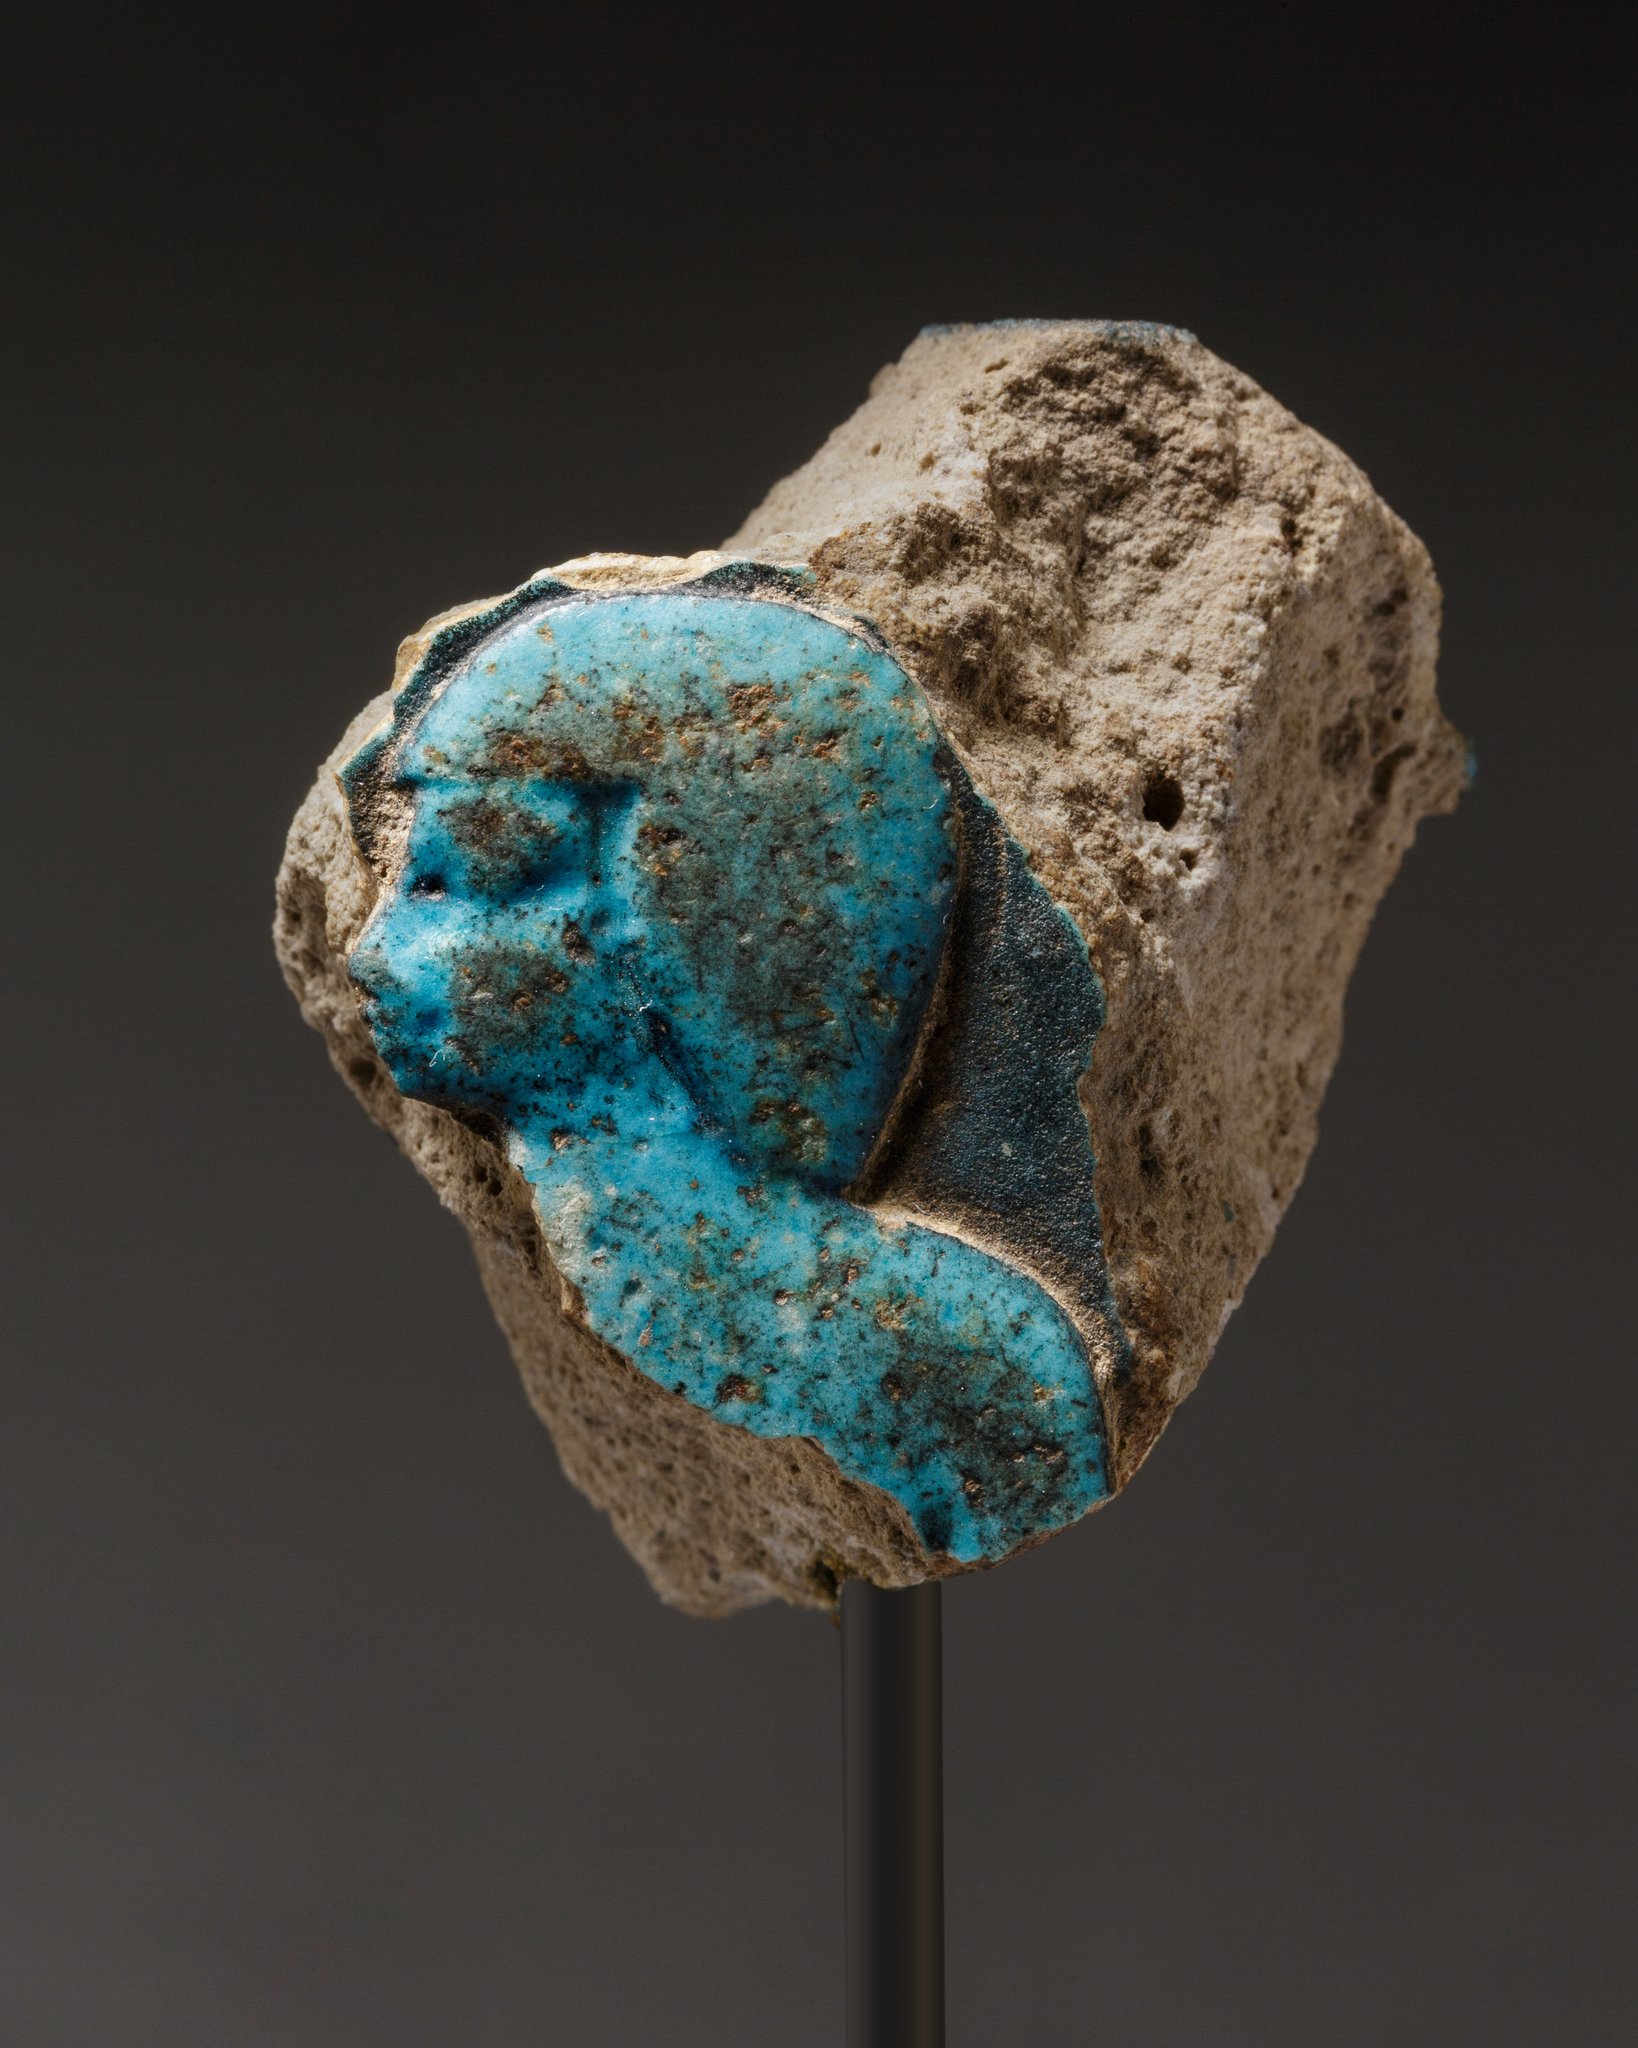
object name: fragment with the head of a man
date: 1981-1650 BCE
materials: faience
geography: egypt